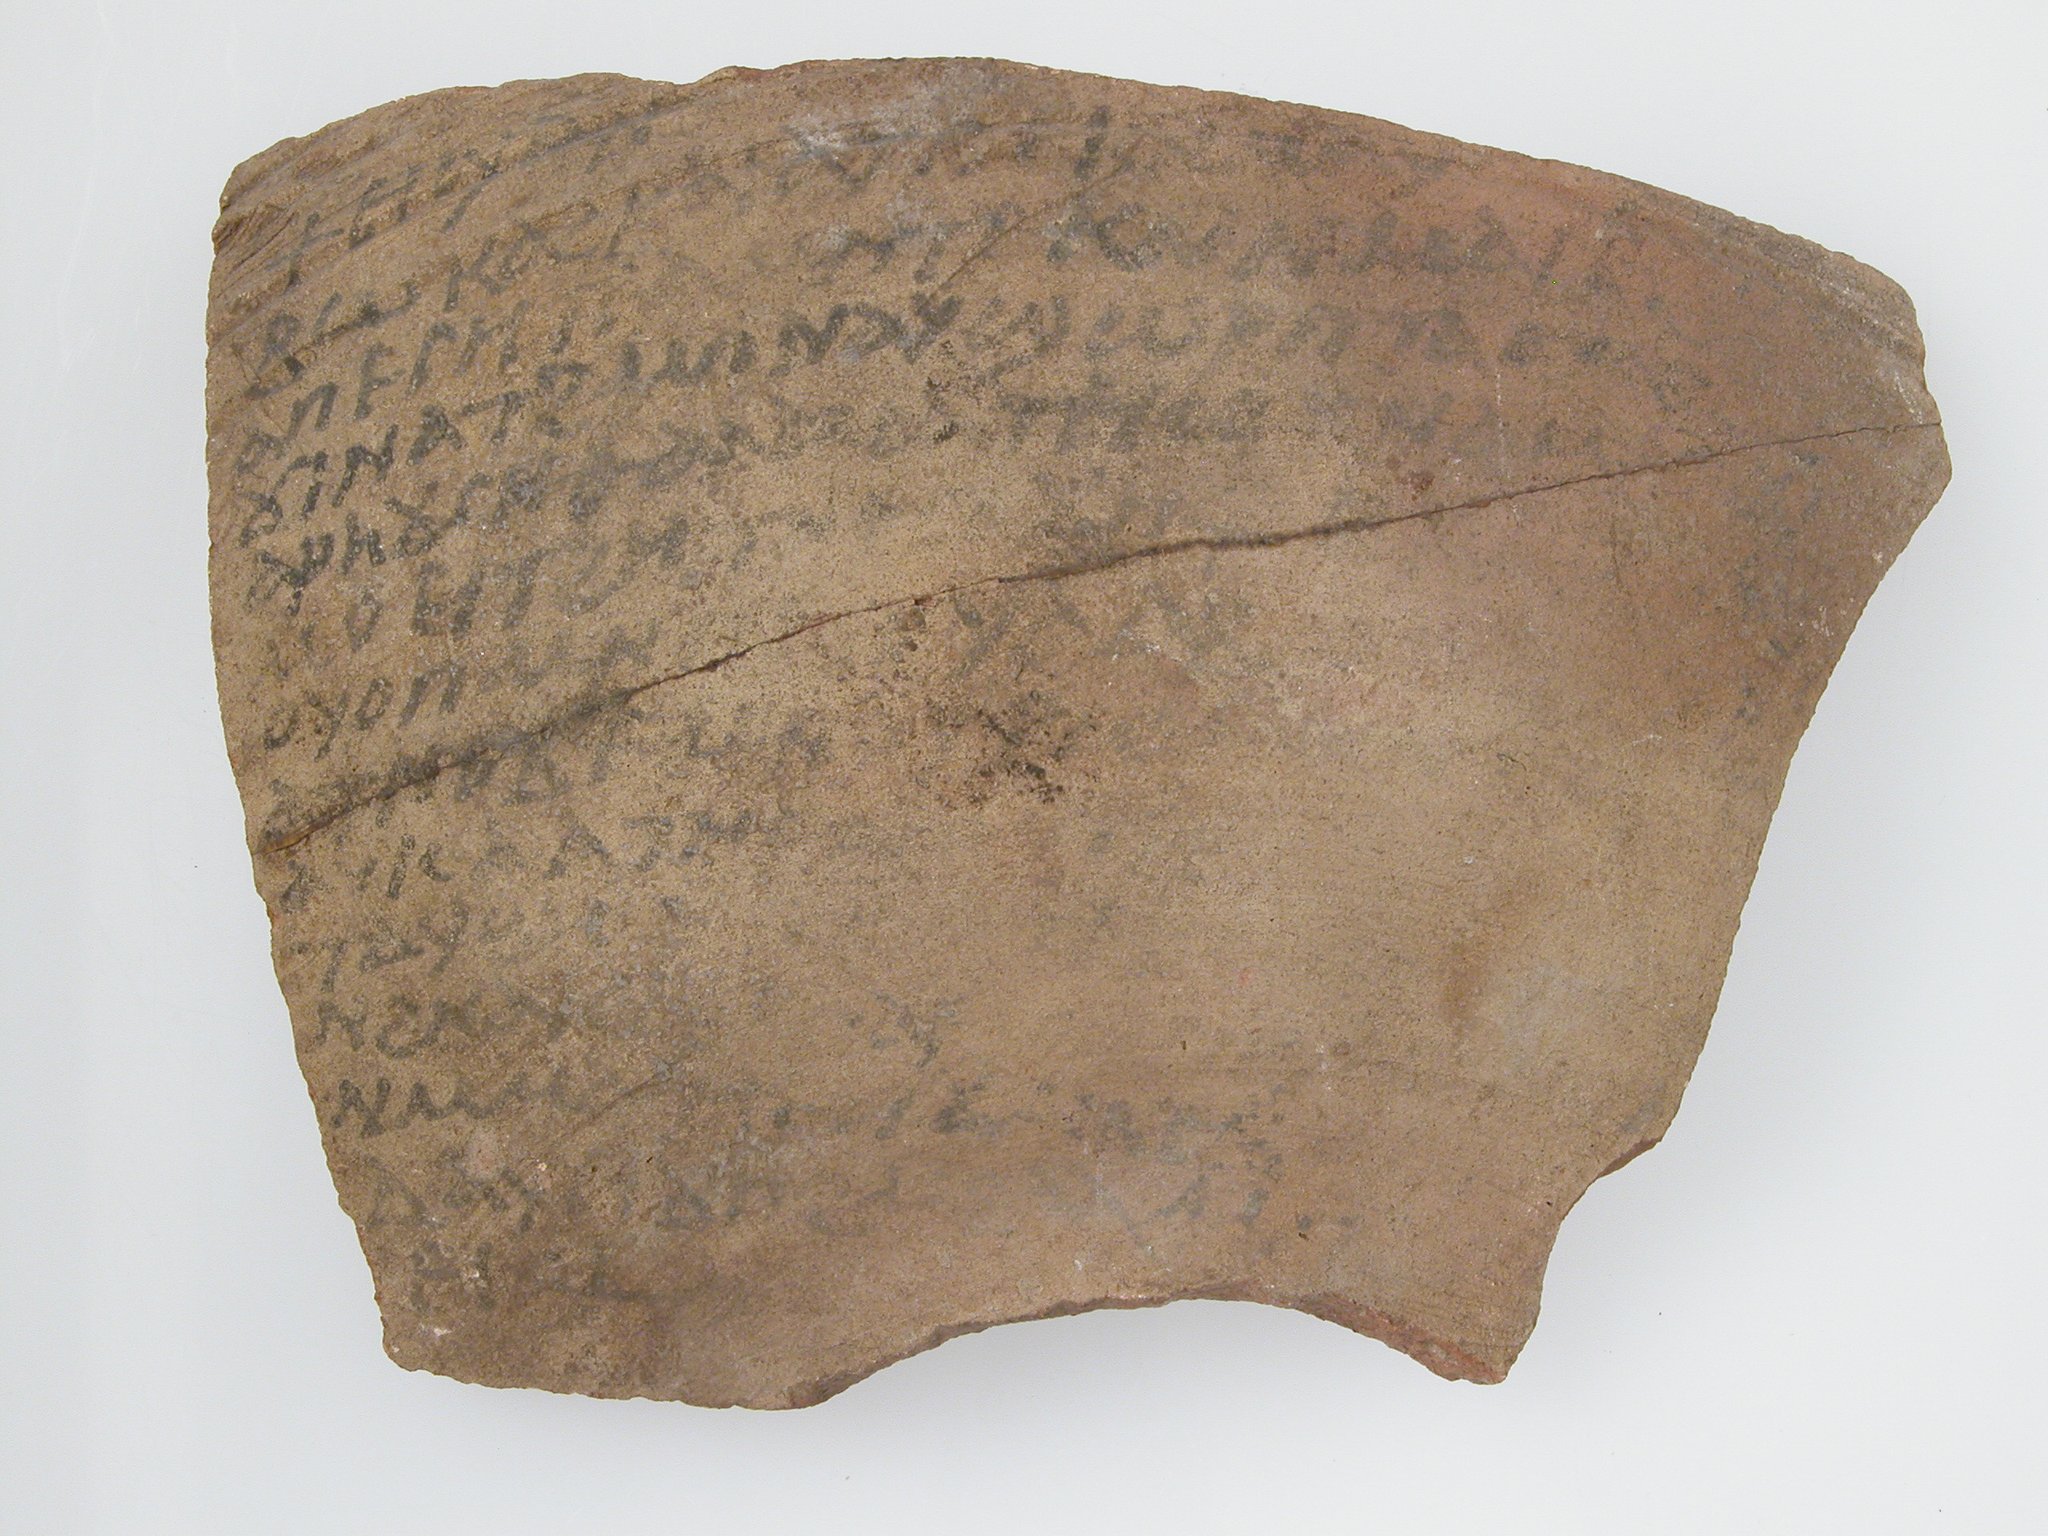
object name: ostrakon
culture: coptic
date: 601-700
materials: ink, pottery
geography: egypt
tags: documents